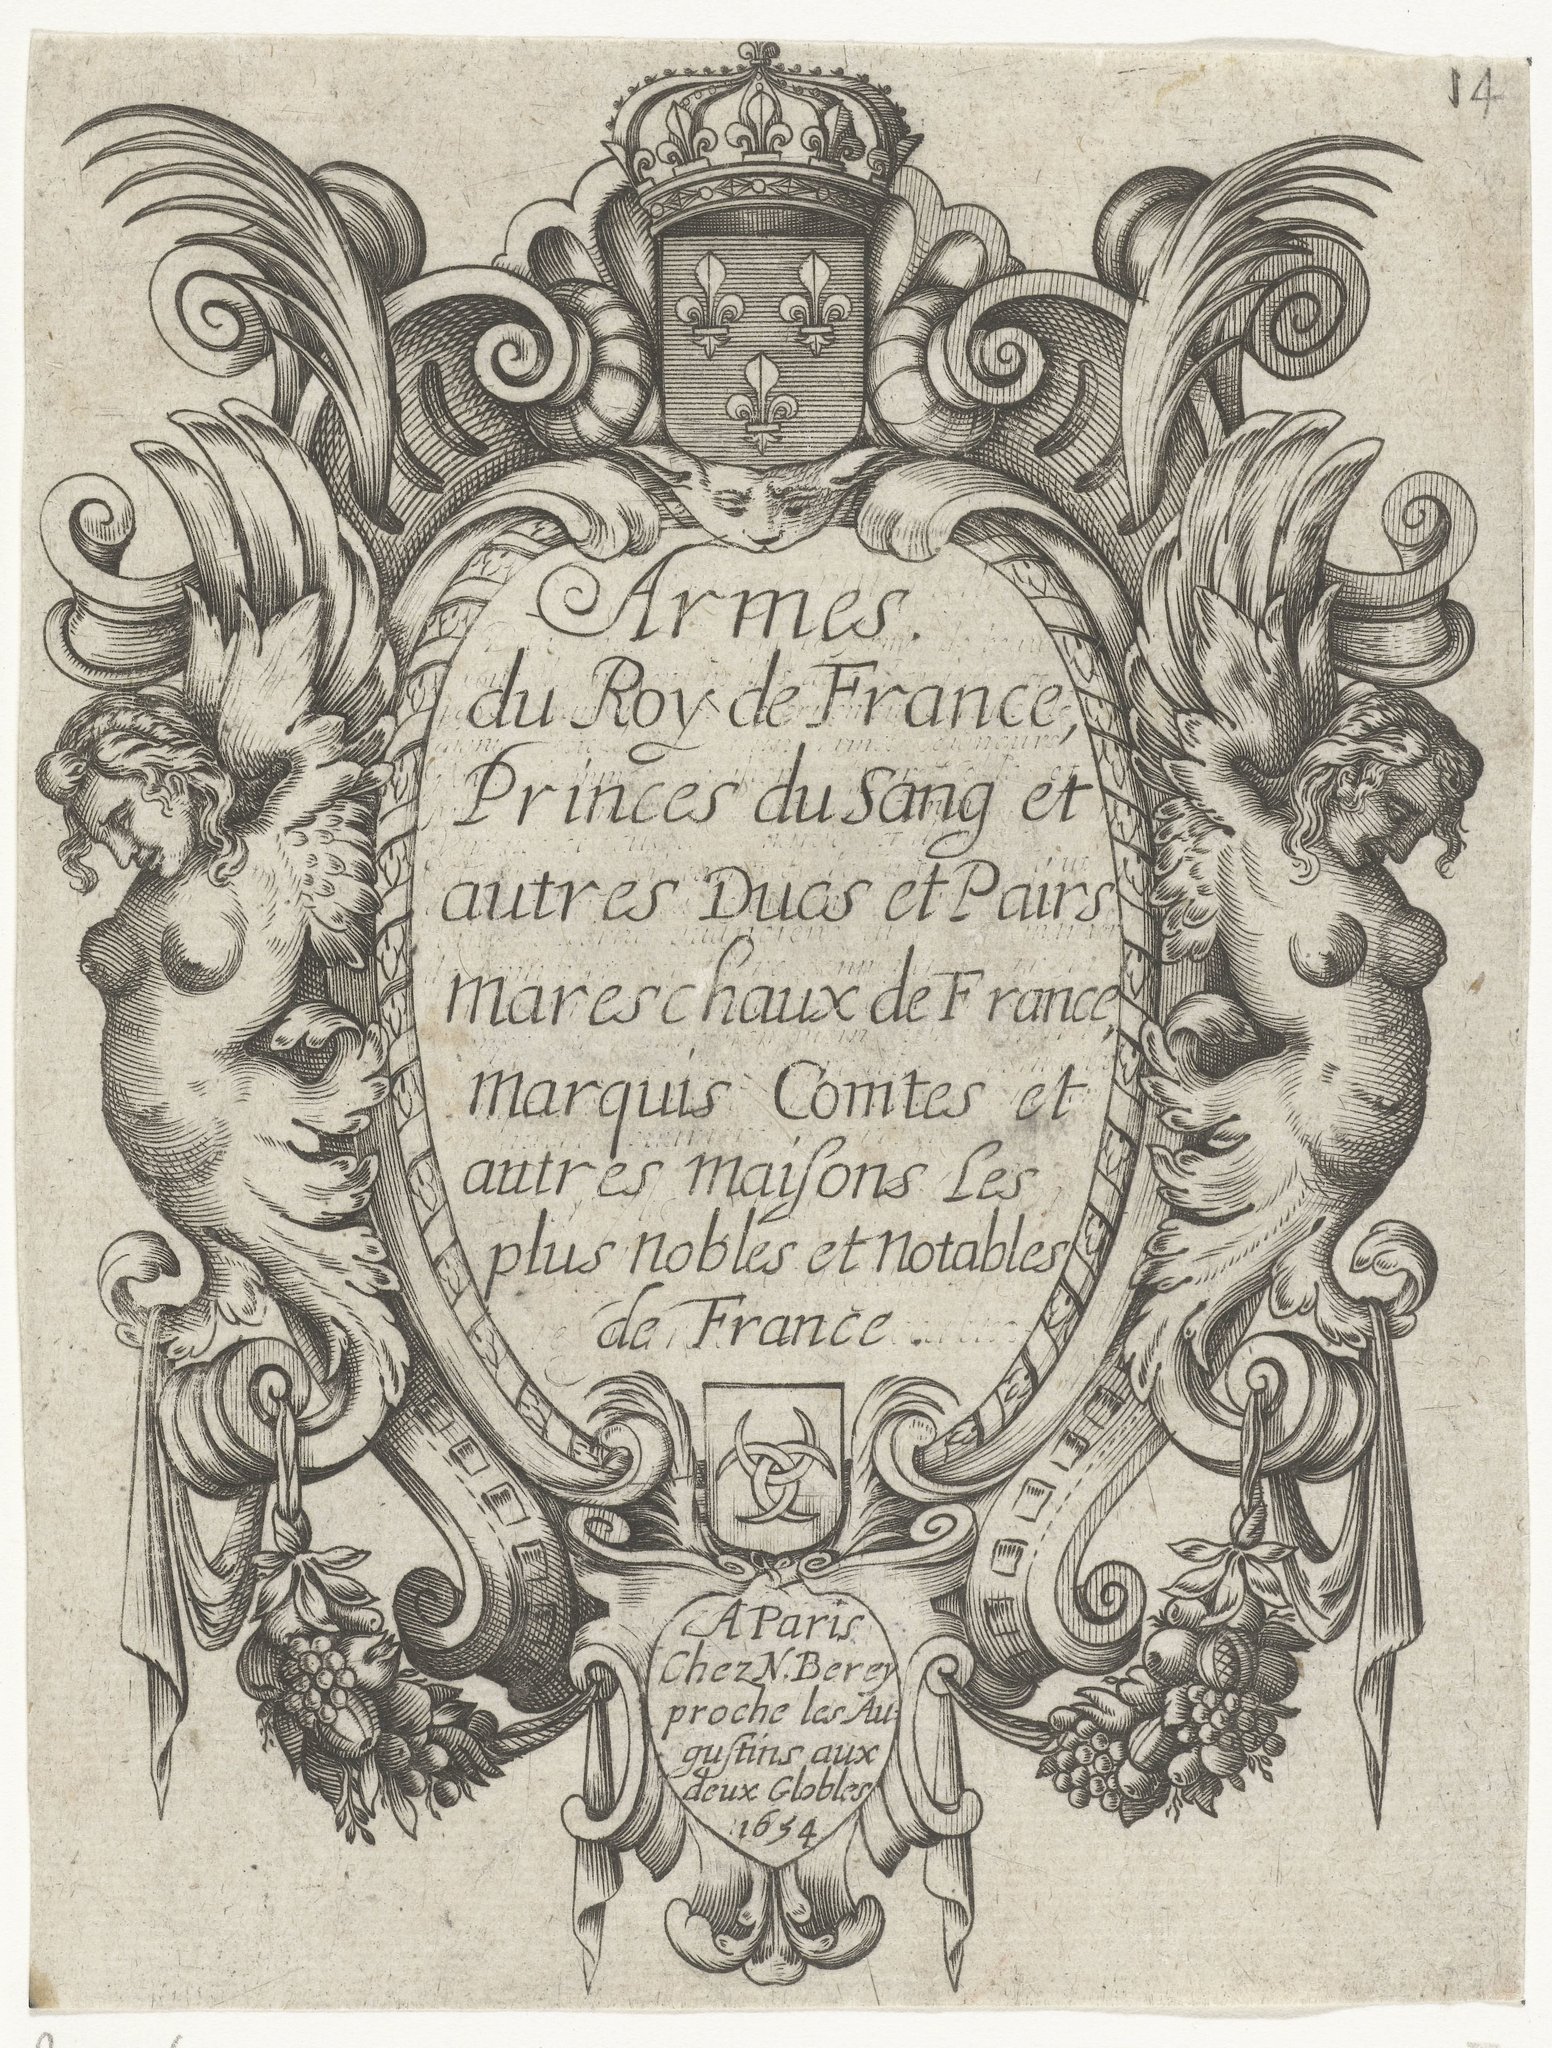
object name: ornament print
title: Cartouche geflankeerd door twee vrouwelijke bovenlichamen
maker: Anonymous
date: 1654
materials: paper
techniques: engraving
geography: france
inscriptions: date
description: Bovenop de cartouche staat het bekroonde Franse wapenschild.